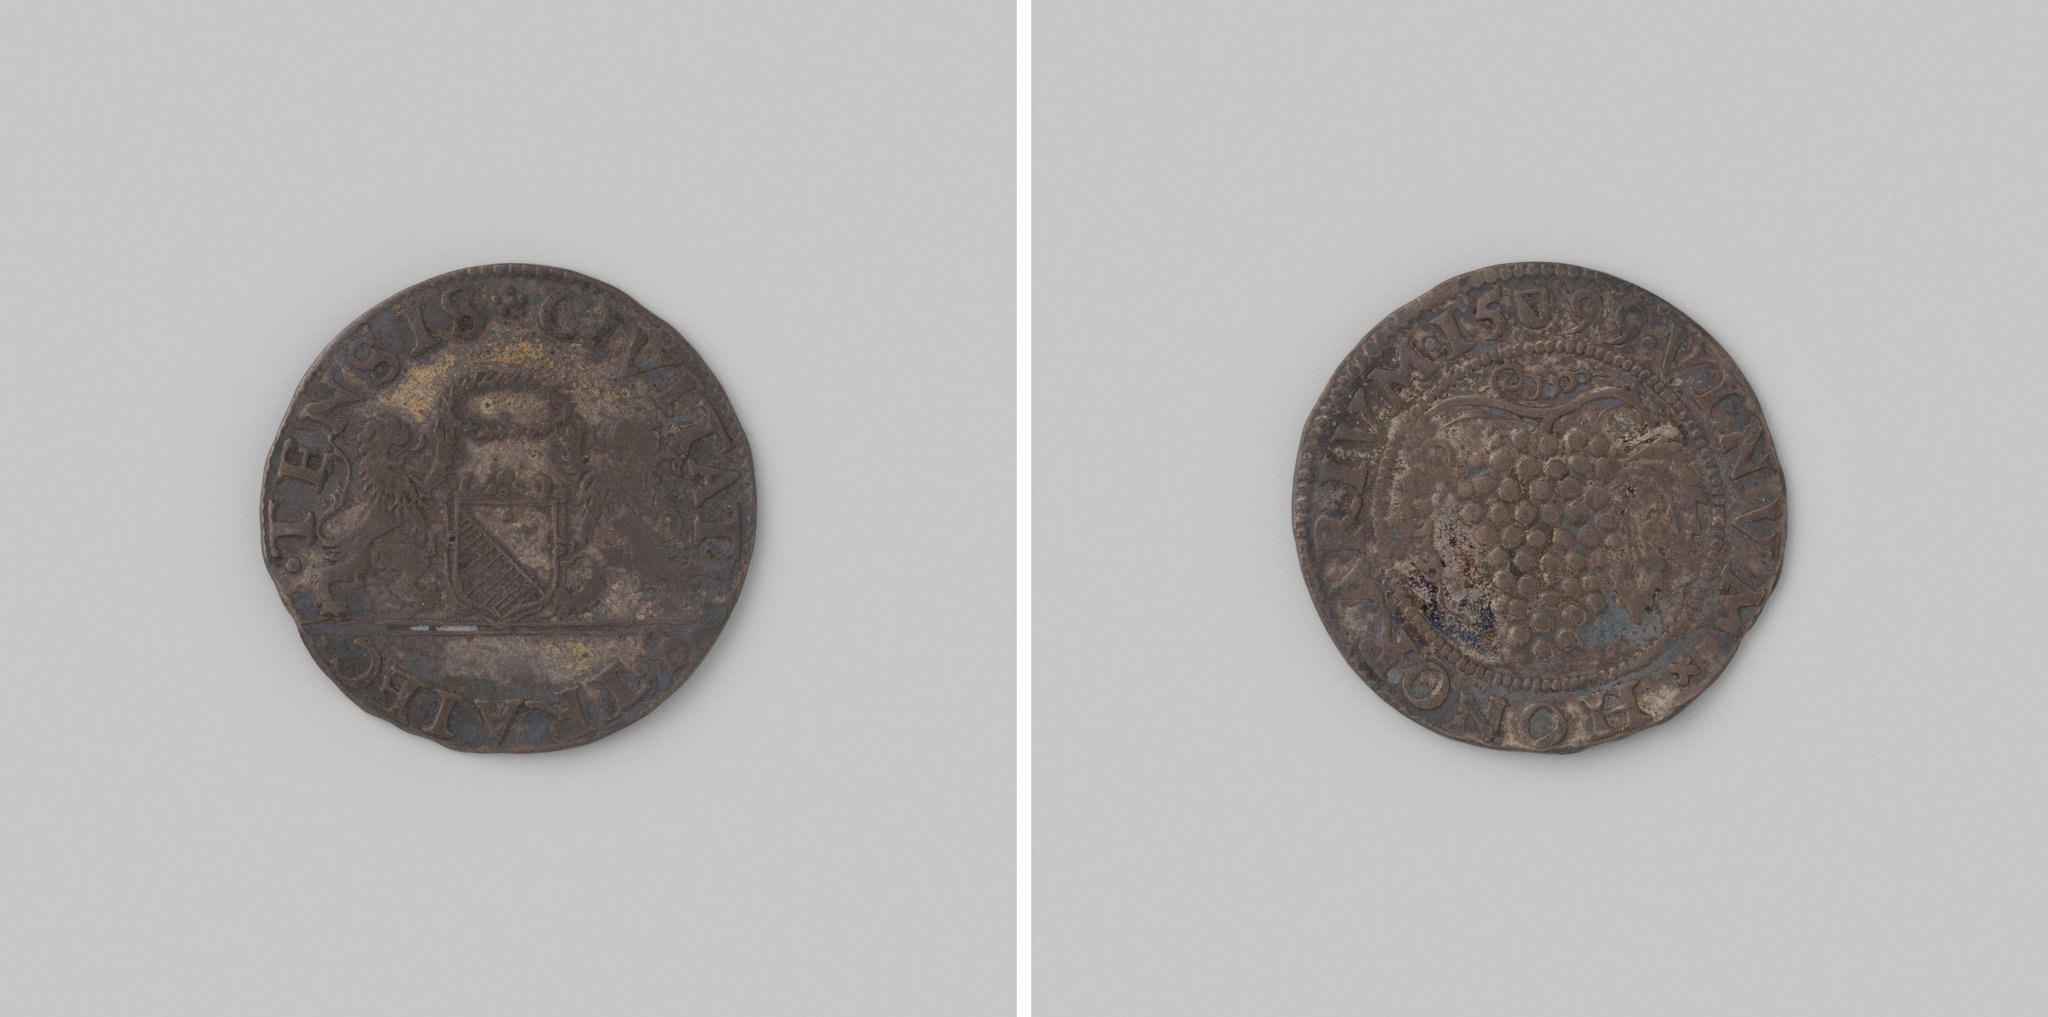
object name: marksman medal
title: Wijnpenning van Utrecht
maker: Anonymous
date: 1599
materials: silver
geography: utrecht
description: Zilveren wijn- en schutterspenning van Utrecht. Voorzijde: stadswapen, waarboven de beide schildhouders (leeuwen) een krans omhoog houden, met omschrift: CIVITATIS TRAJECTENSIS (Van de stad Utrecht). Keerzijde: een druiventros, met omschrift: VINUM HONORARIVM (Erewijn), met het jaartal 1599. Tussen 15 en 99 is een wapen van Utrecht geslagen.